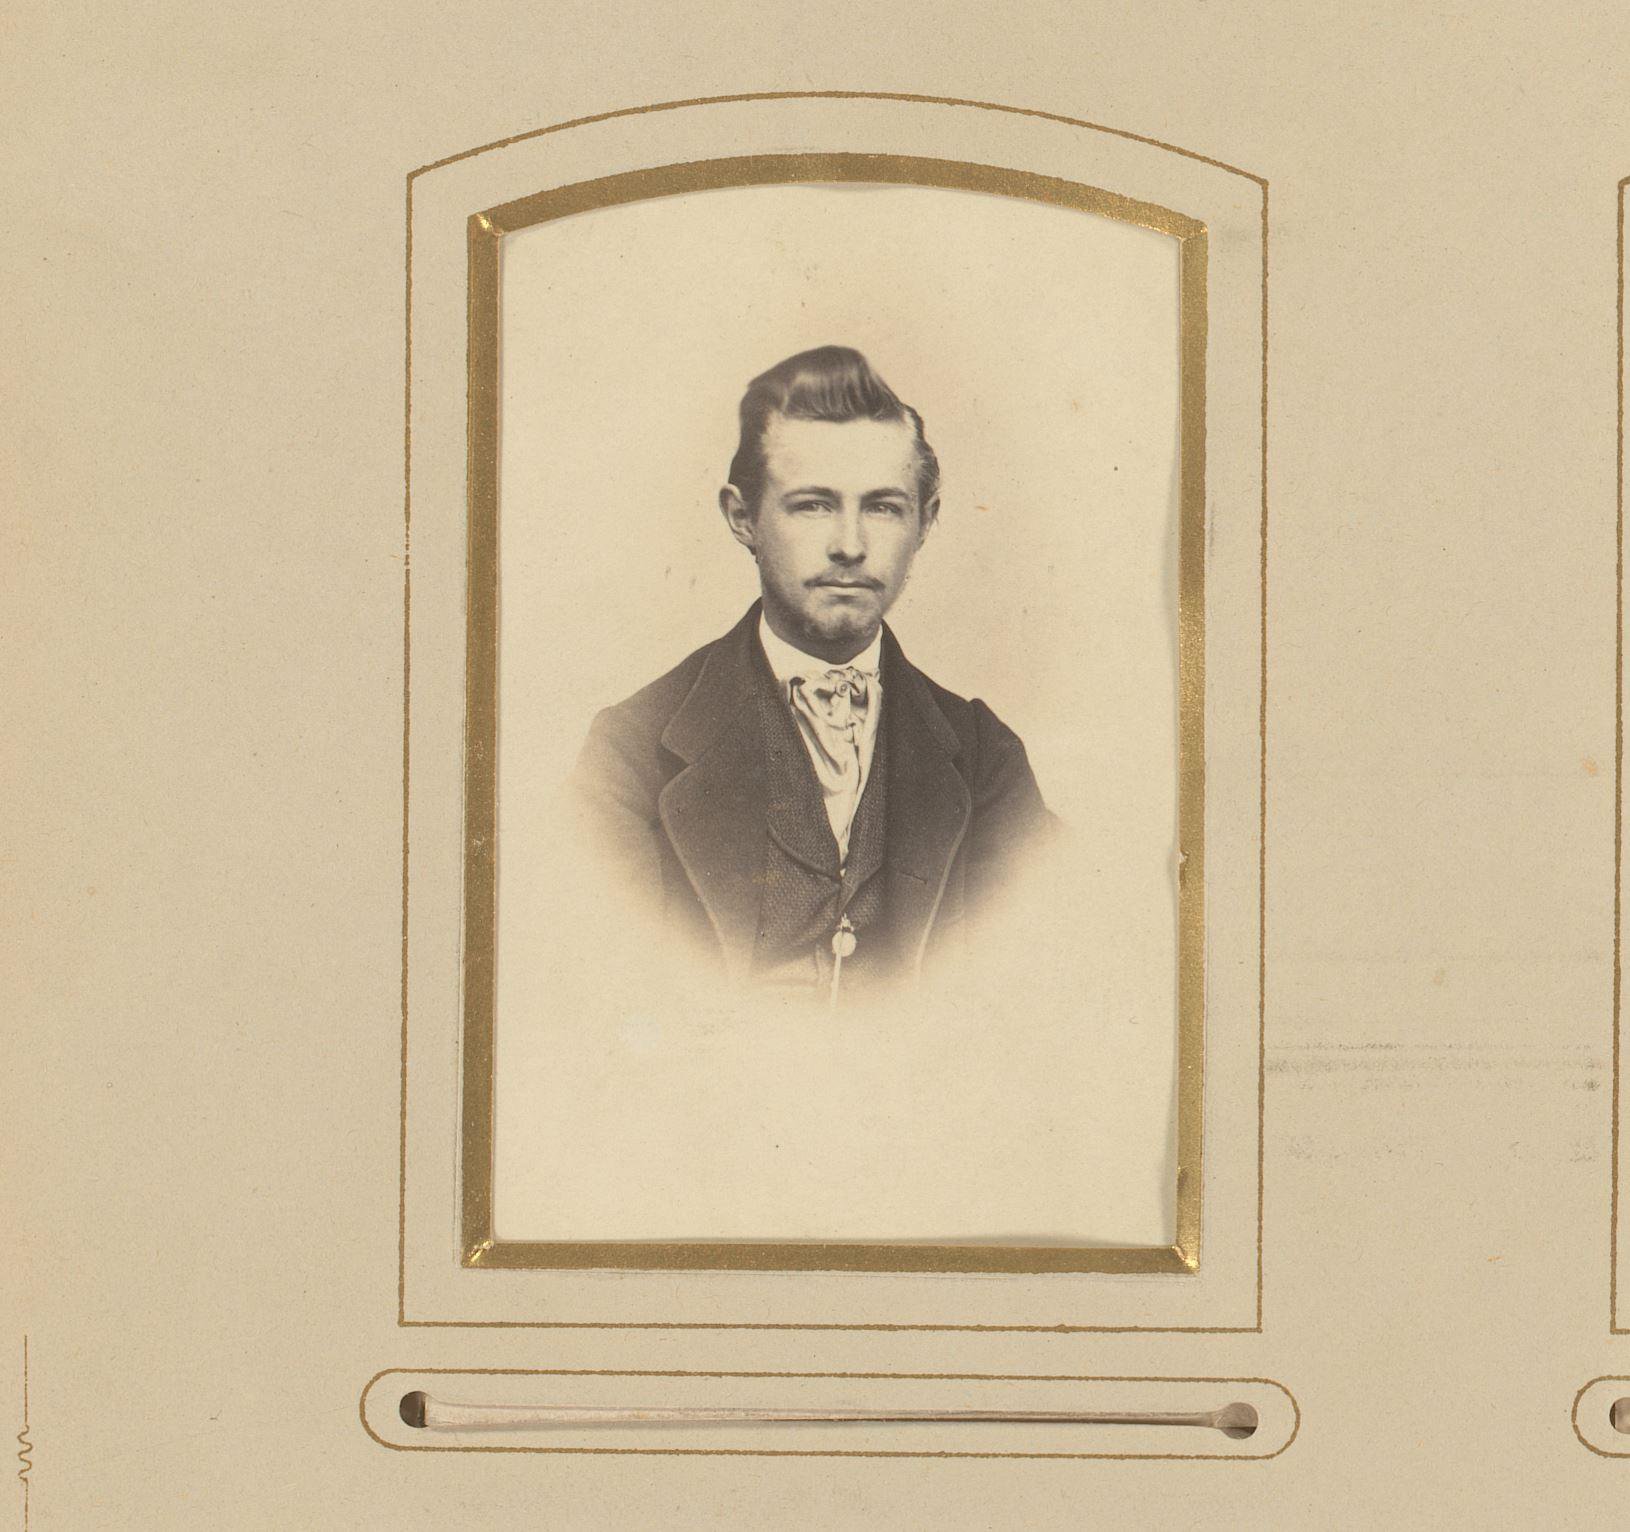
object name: photograph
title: Portret van een jonge man met snor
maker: Anonymous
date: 1850-1900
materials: cardboard, photographic support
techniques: albumen print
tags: moustache, historical persons, youth, adolescent